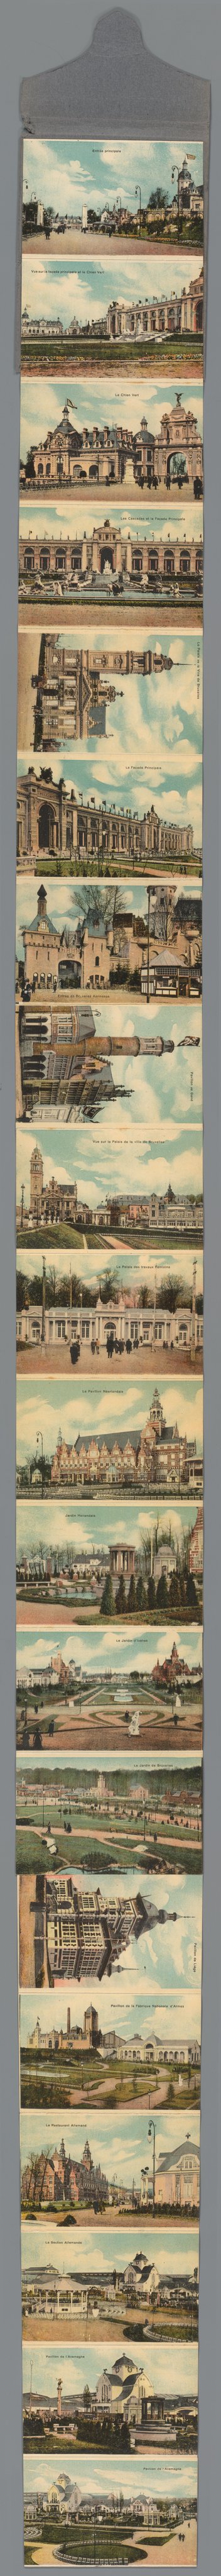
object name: accordion book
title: Souvenir de l'exposition universelle de Bruxelles 1910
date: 1910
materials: cardboard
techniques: photograph, lithograph, letterpress printing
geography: brussels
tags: world fair, world exhibition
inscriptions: monogram: ‘F.M.Br.’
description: Leporelloalbum met eenentwintig prentbriefkaarten.